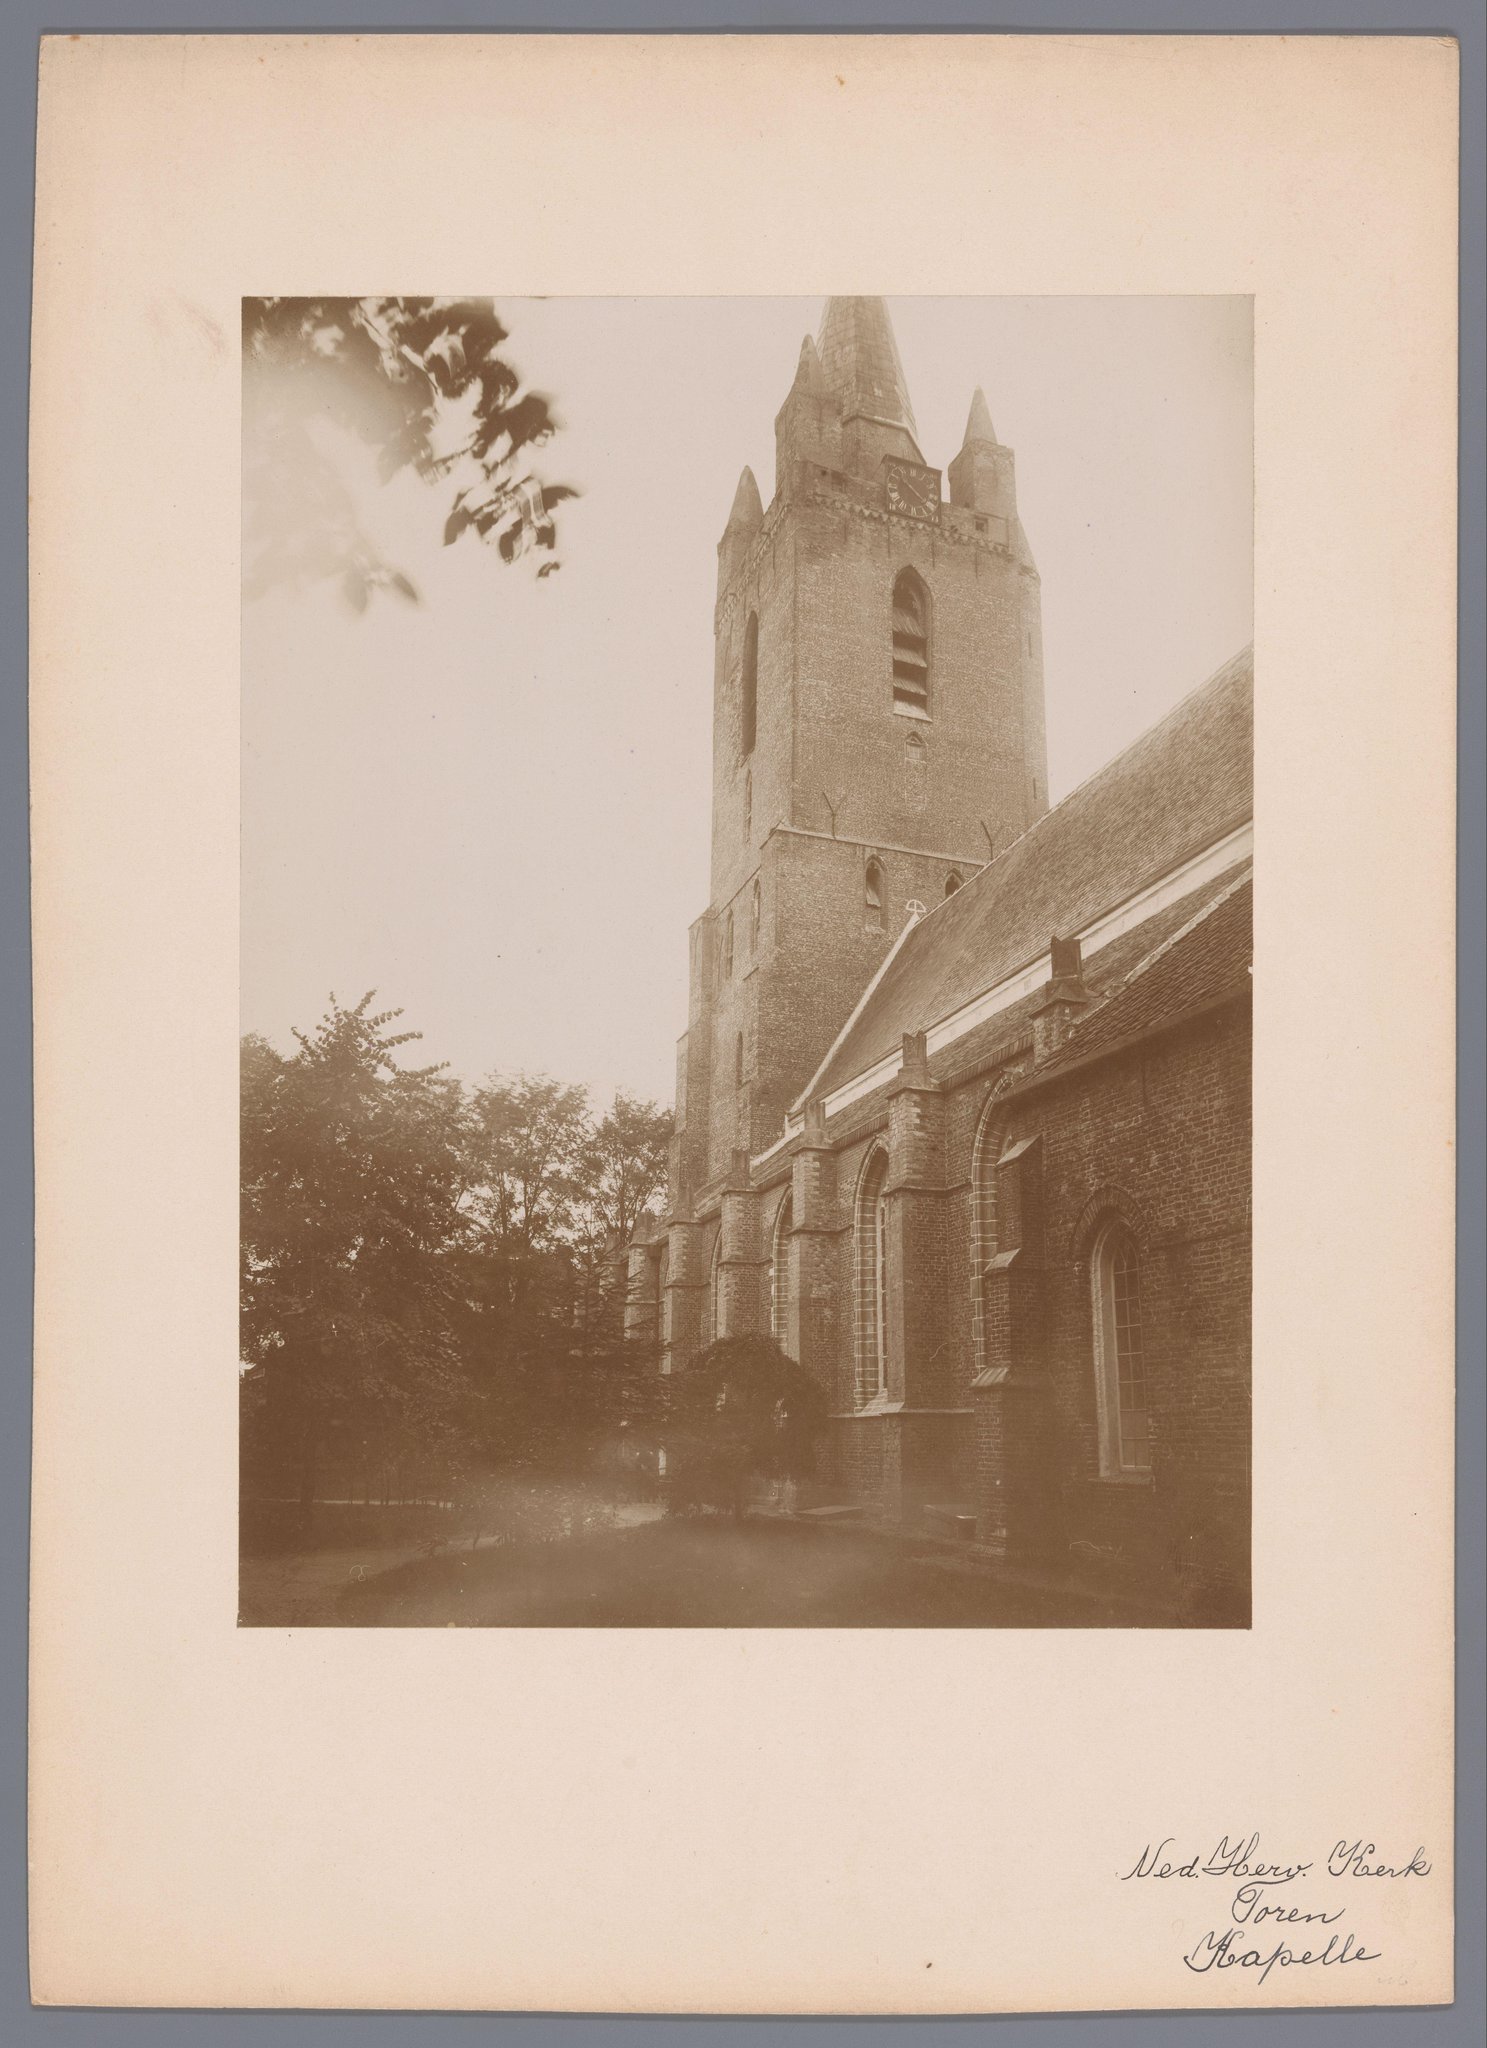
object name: photograph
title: Toren van de Hervormde Kerk te Kapelle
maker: anoniem (monumentenzorg)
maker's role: fotograaf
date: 1896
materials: cardboard, photographic support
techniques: collodion silver print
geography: kapelle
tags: parts of church exterior and annexes: tower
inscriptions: annotation: ‘Ned. Herv. Kerk/ Toren/ Kapelle’, annotation: ‘Kapelle Z.B. (Zeeland)/ Toren v/d Ned Herv. Kerk/ oct 1896’